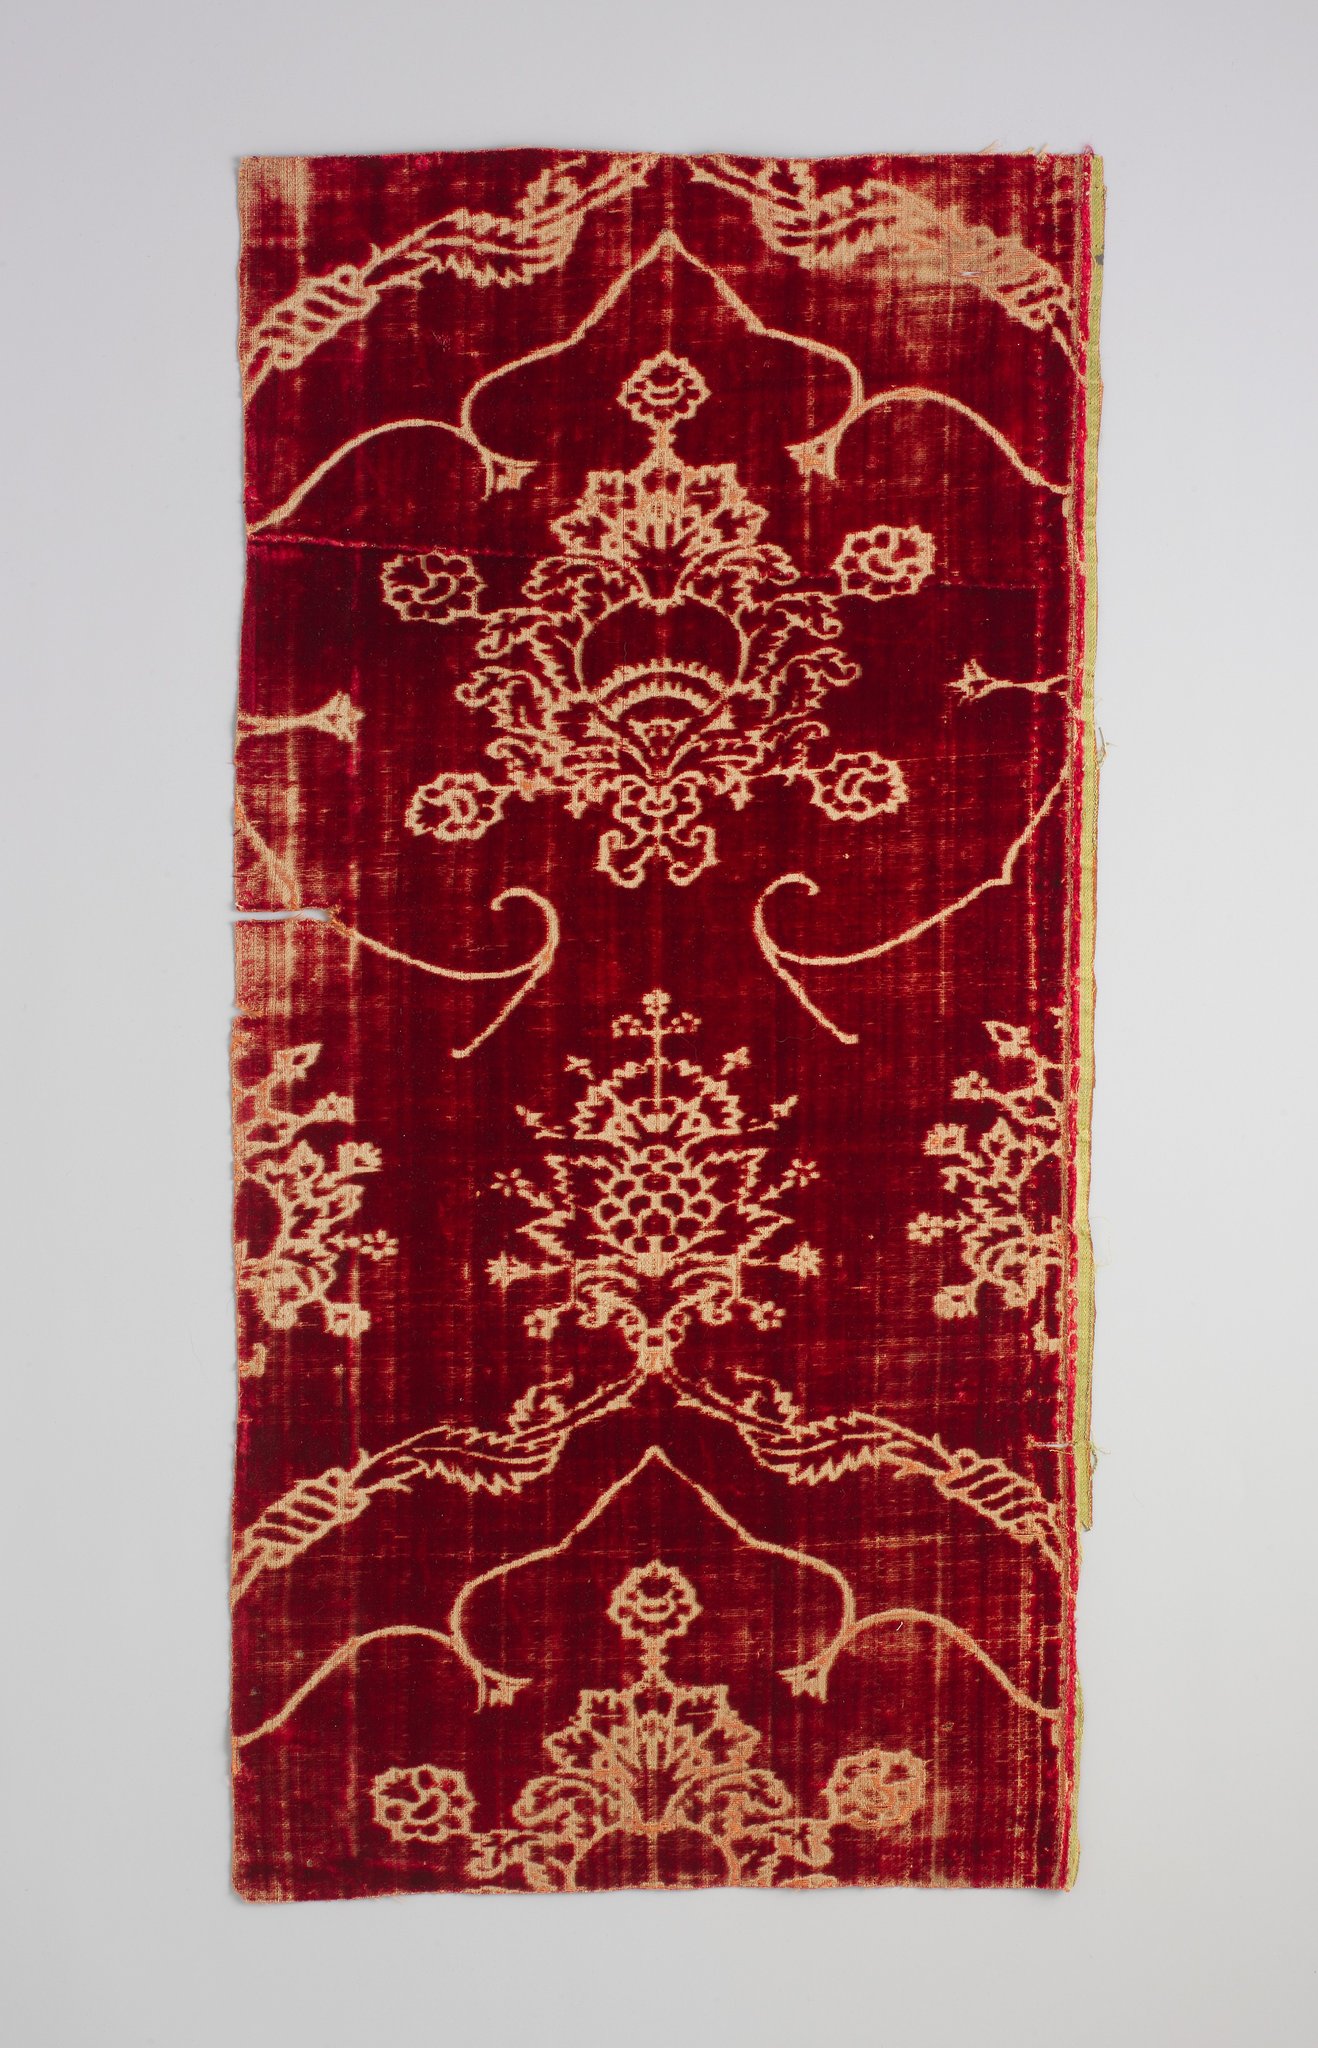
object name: piece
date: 1451-1500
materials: silk